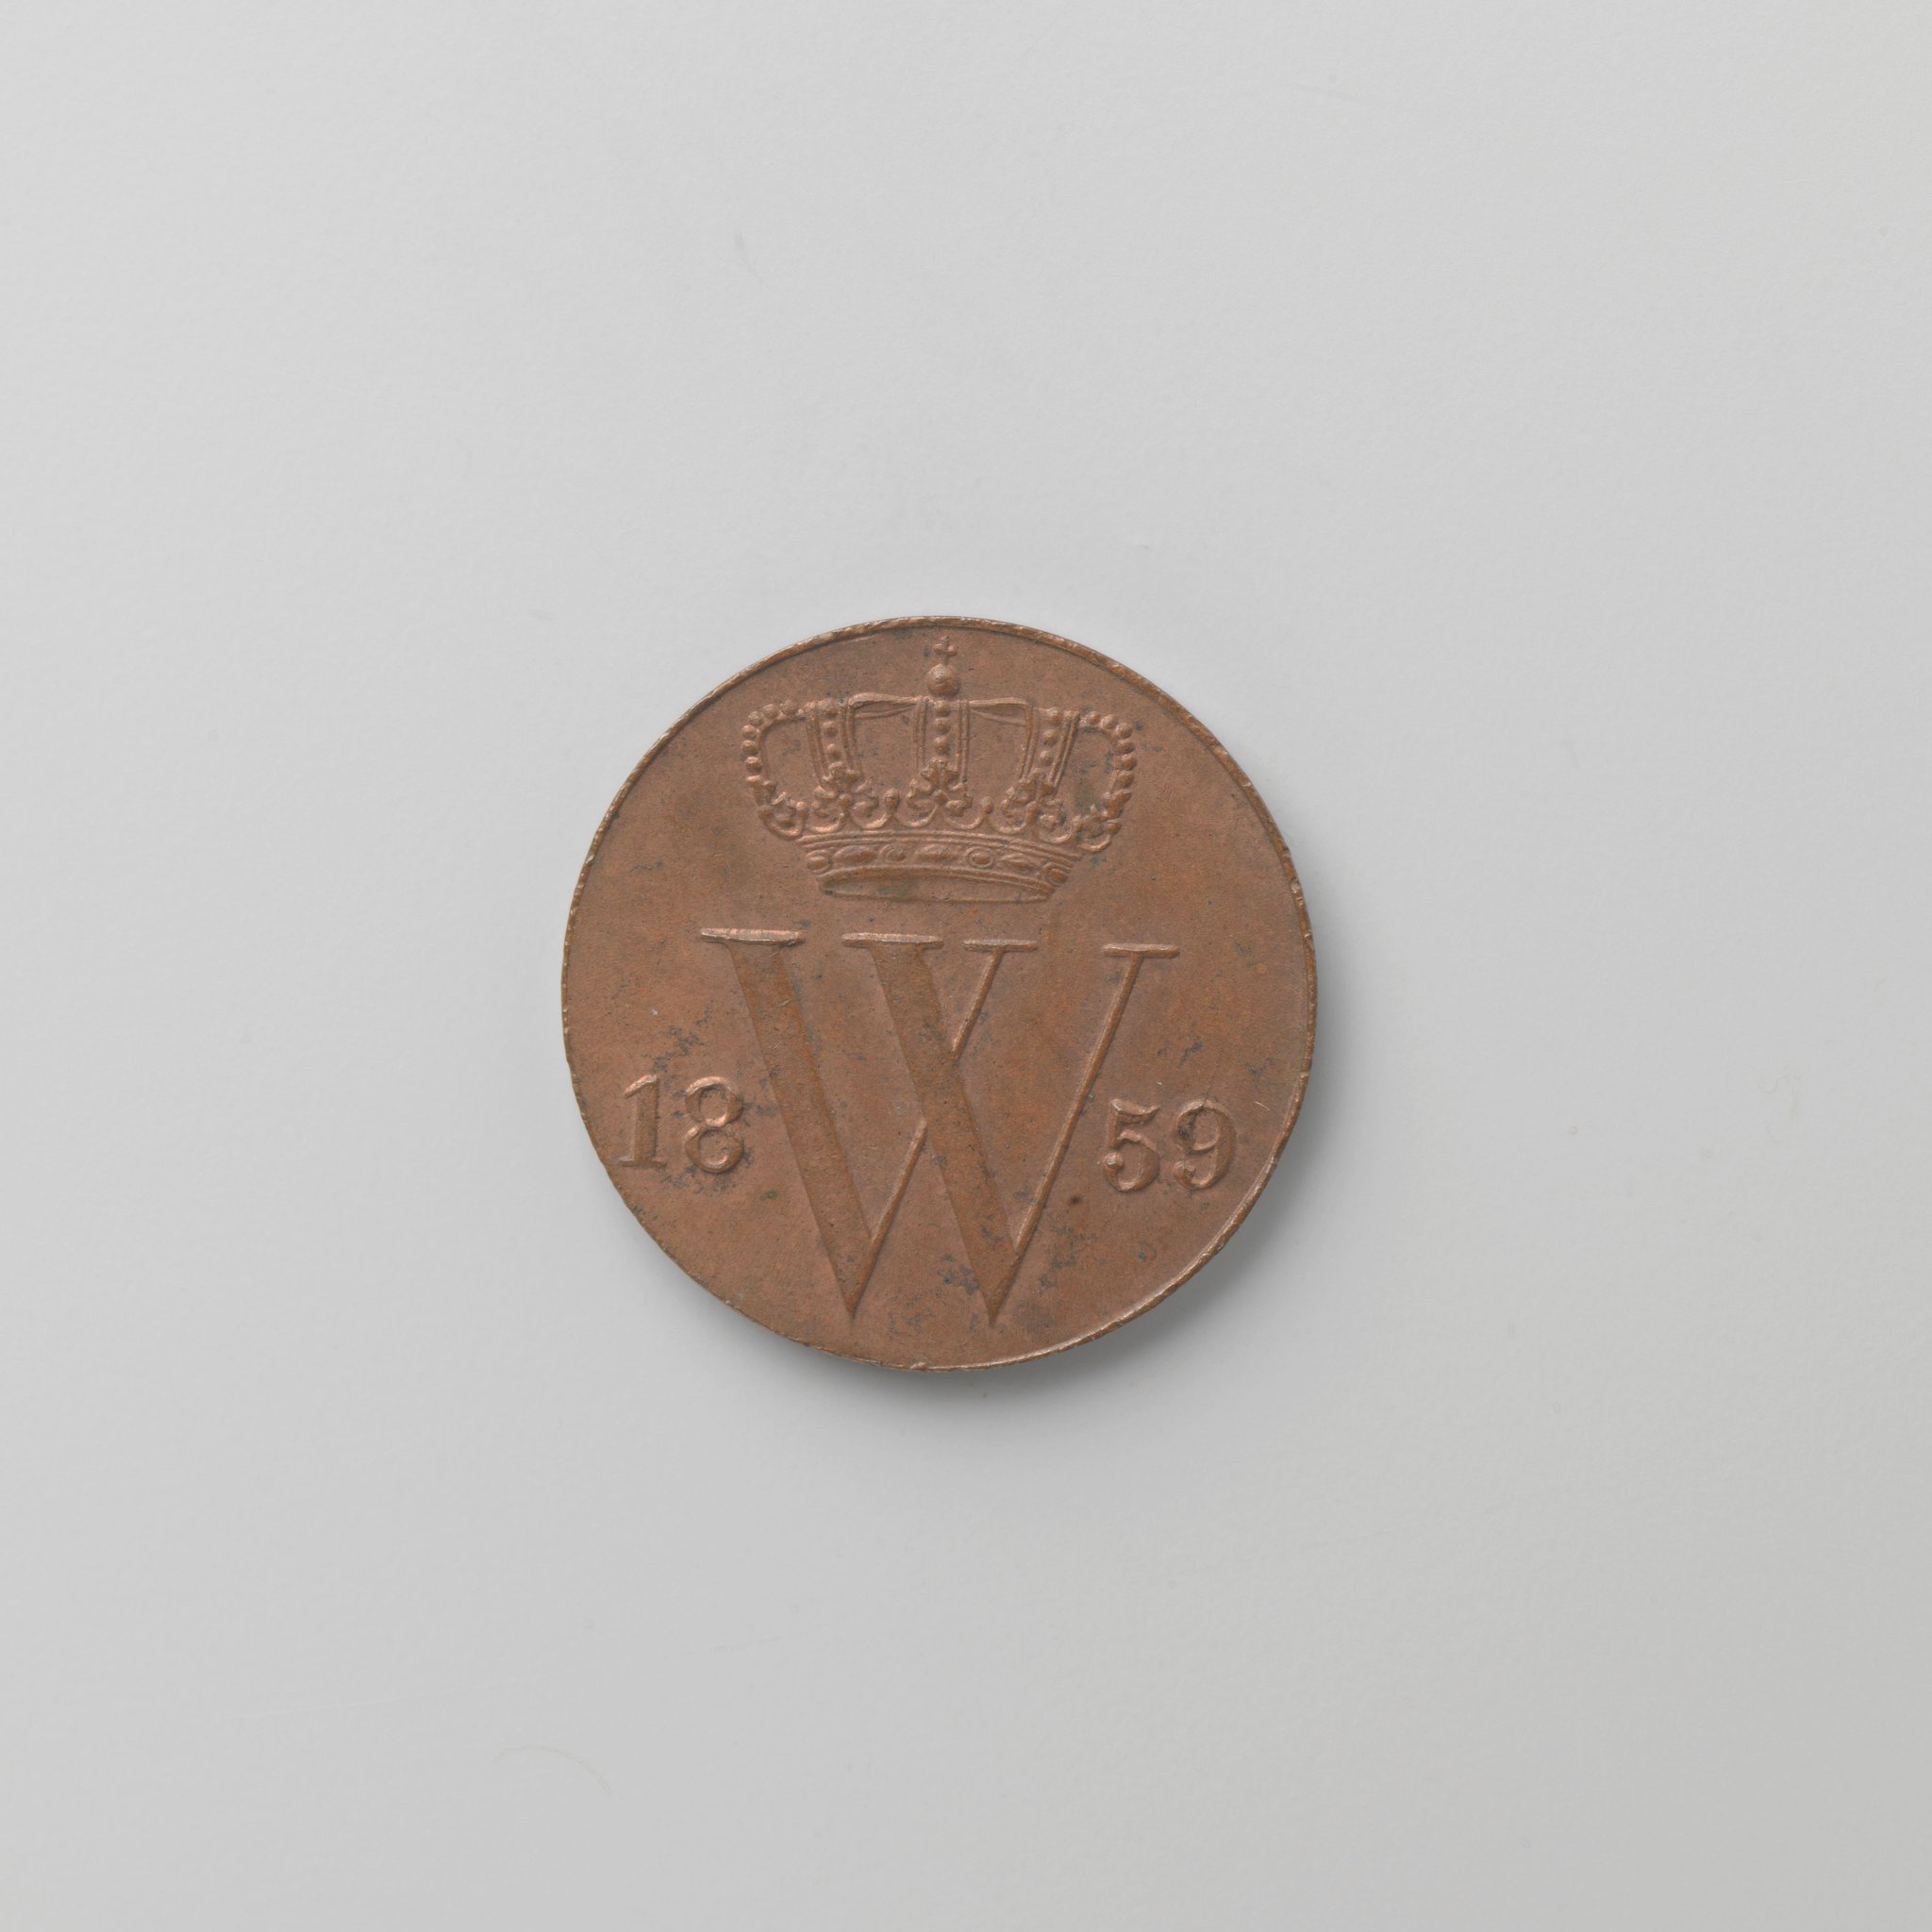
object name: coin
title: Nederland, ½ cent, 1859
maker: willem iii (koning der nederlanden)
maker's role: koning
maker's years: 1817-1890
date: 1859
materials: copper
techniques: striking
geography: utrecht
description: Koperen munt. Voorzijde: tussen jaartal gekroonde rechte letter W. Keerzijde: tussen waarde-aanduiding ½ C. gekroond rijkswapenschild. Gladde rand.